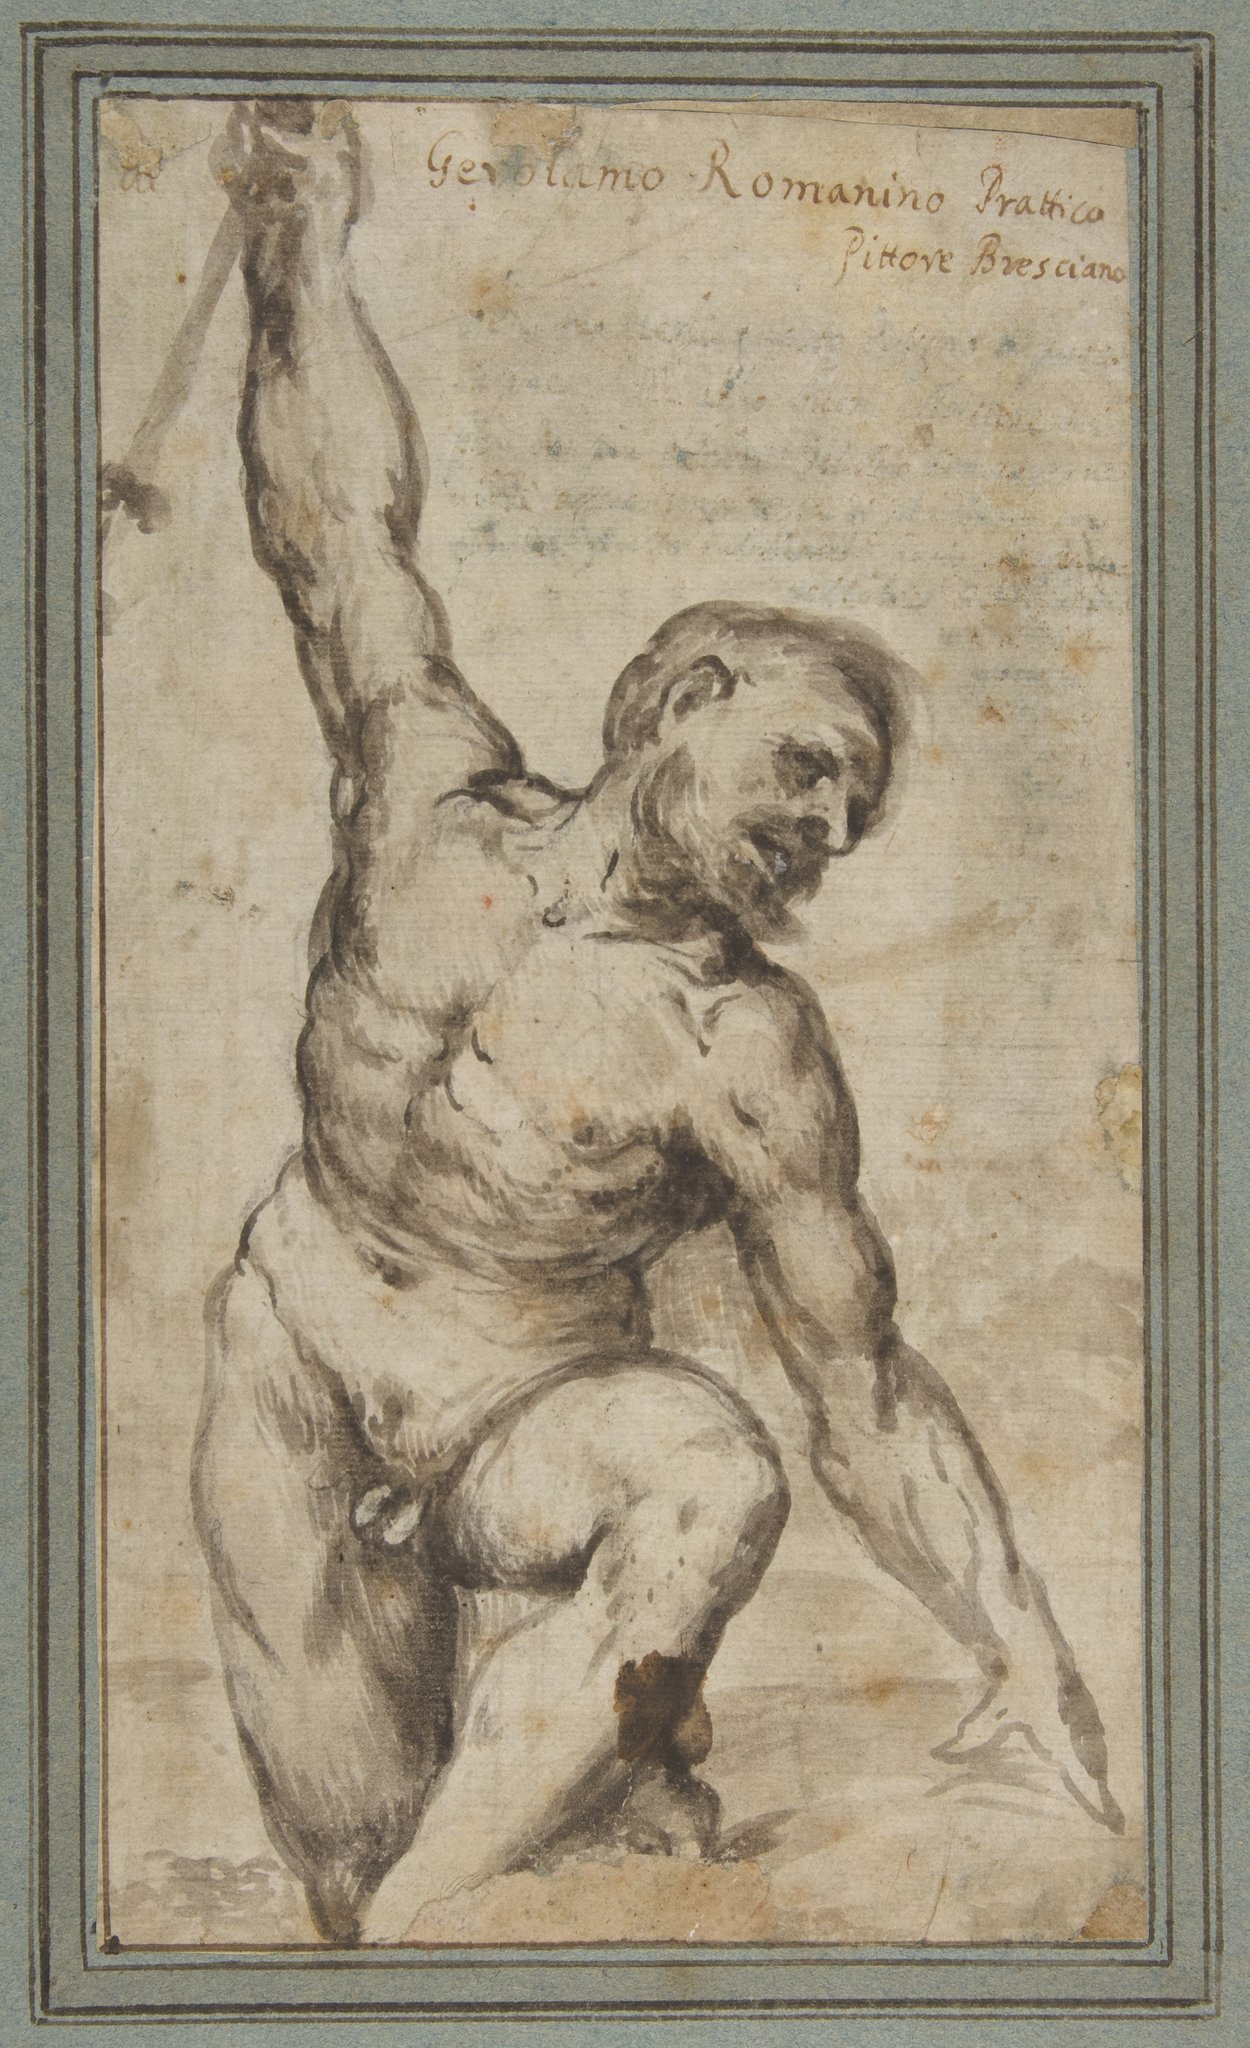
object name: drawing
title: Nude Male Figure with Upraised Right Arm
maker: girolamo romanino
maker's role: artist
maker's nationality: italian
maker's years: 1484-1560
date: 1550-1560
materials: chalk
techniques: brush, wash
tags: male nudes